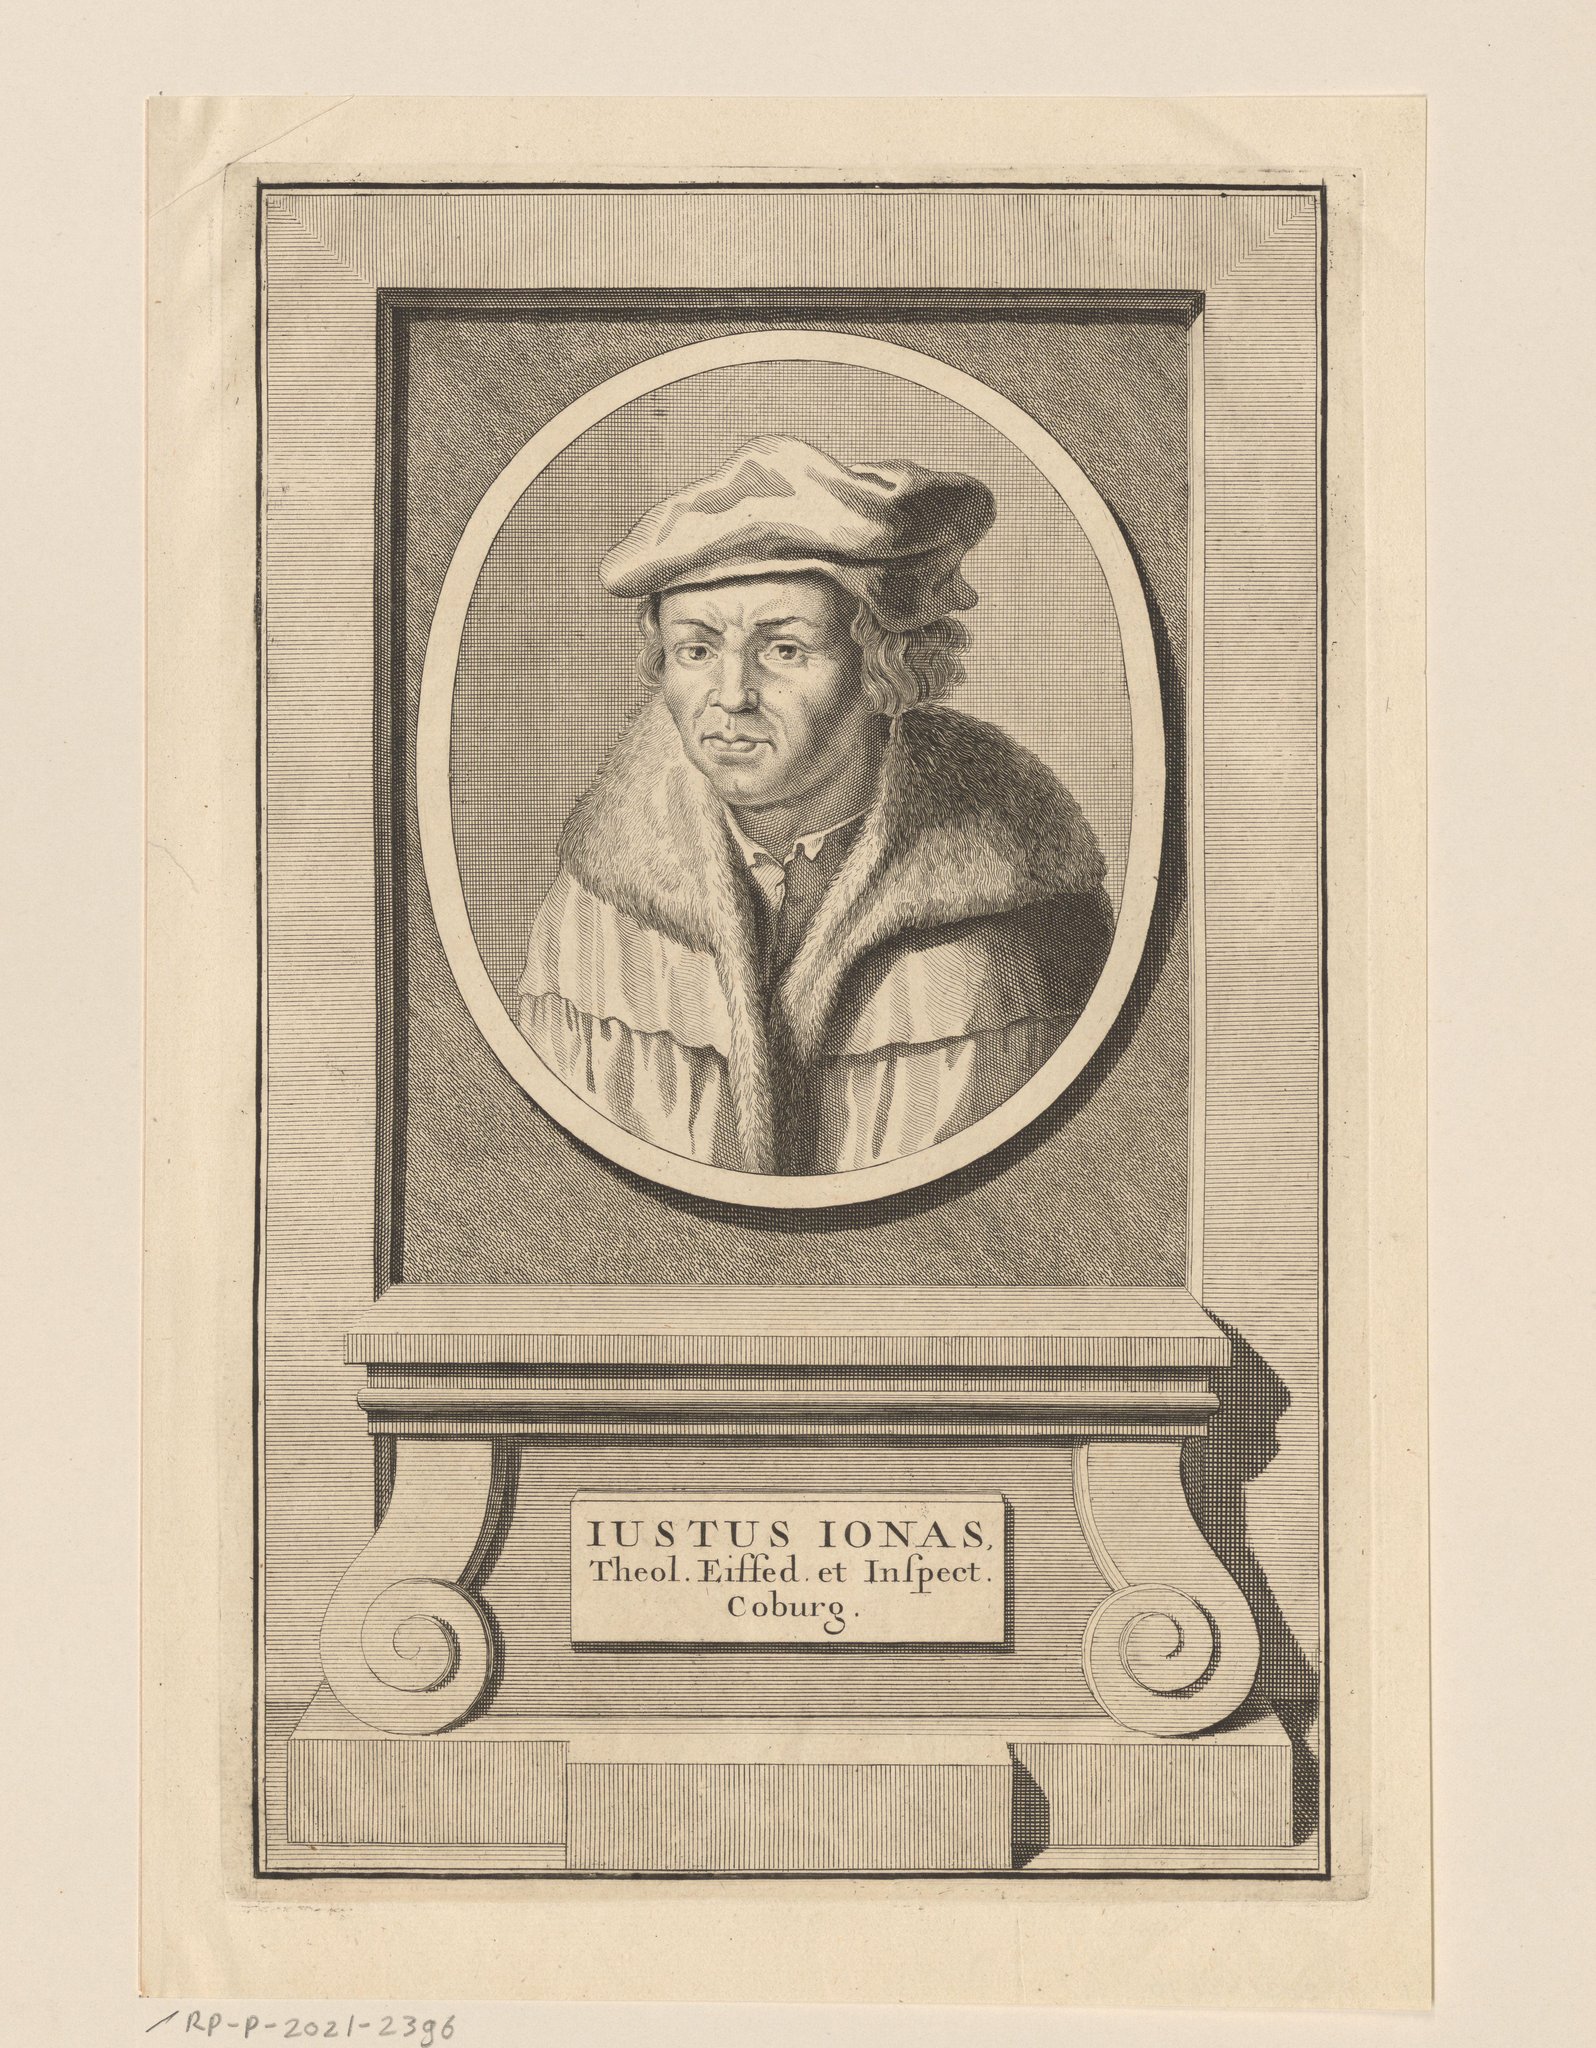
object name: print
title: Portret van Justus Jonas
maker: Anonymous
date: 1728-1734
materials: paper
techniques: engraving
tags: theologian, historical persons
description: Prent mogelijk uit: Seckendorf, Veit-Ludwig von. Uitvoerige en onpartydige historie der reformatie door Martin Luther (...). Delft: Reinier Boitet, 1728, dl. 1. Of uit: De goude en zilvere eergedagtenis van Dr. M. Luther (...). Den Haag: s.n., 1734. Prent mogelijk ook gebruikt in andere publicaties.